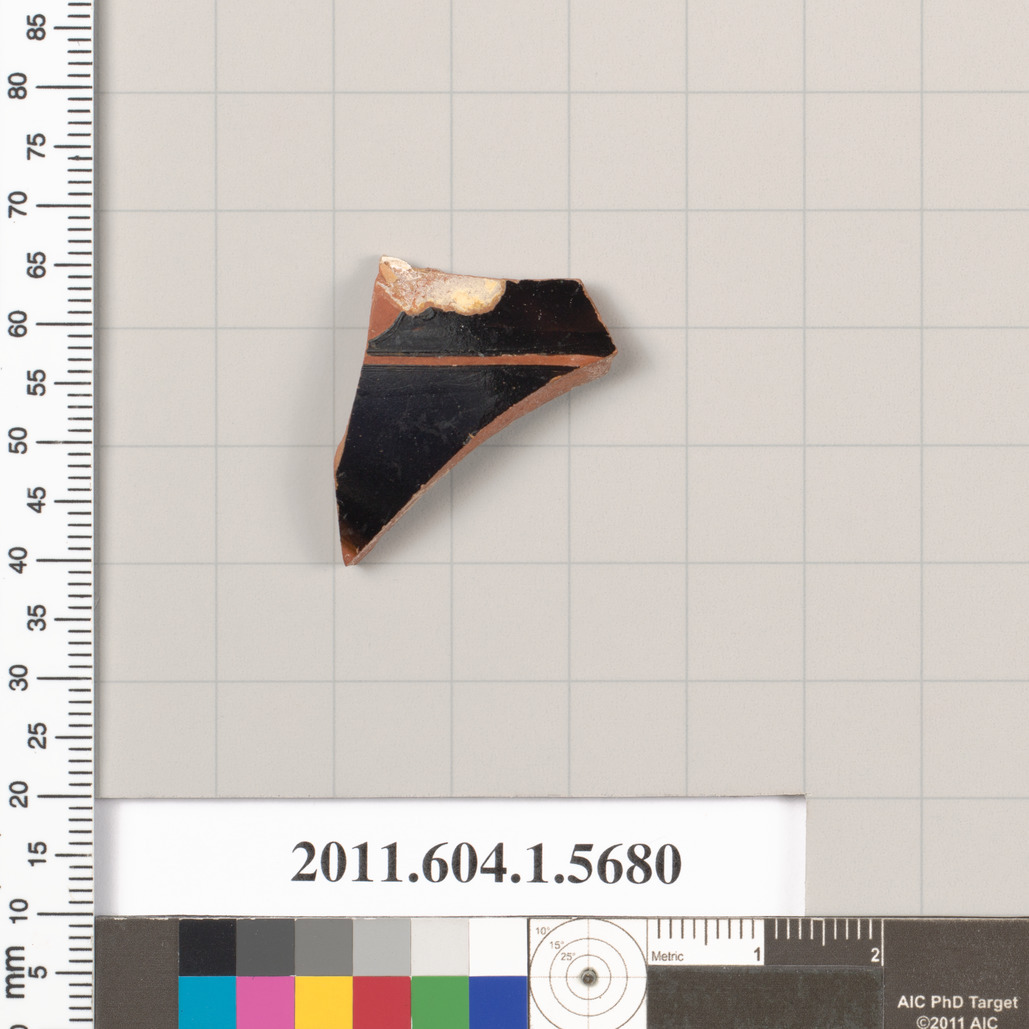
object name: kylix fragment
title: Terracotta fragment of a kylix (drinking cup)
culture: greek, attic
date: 500-480 BCE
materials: terracotta